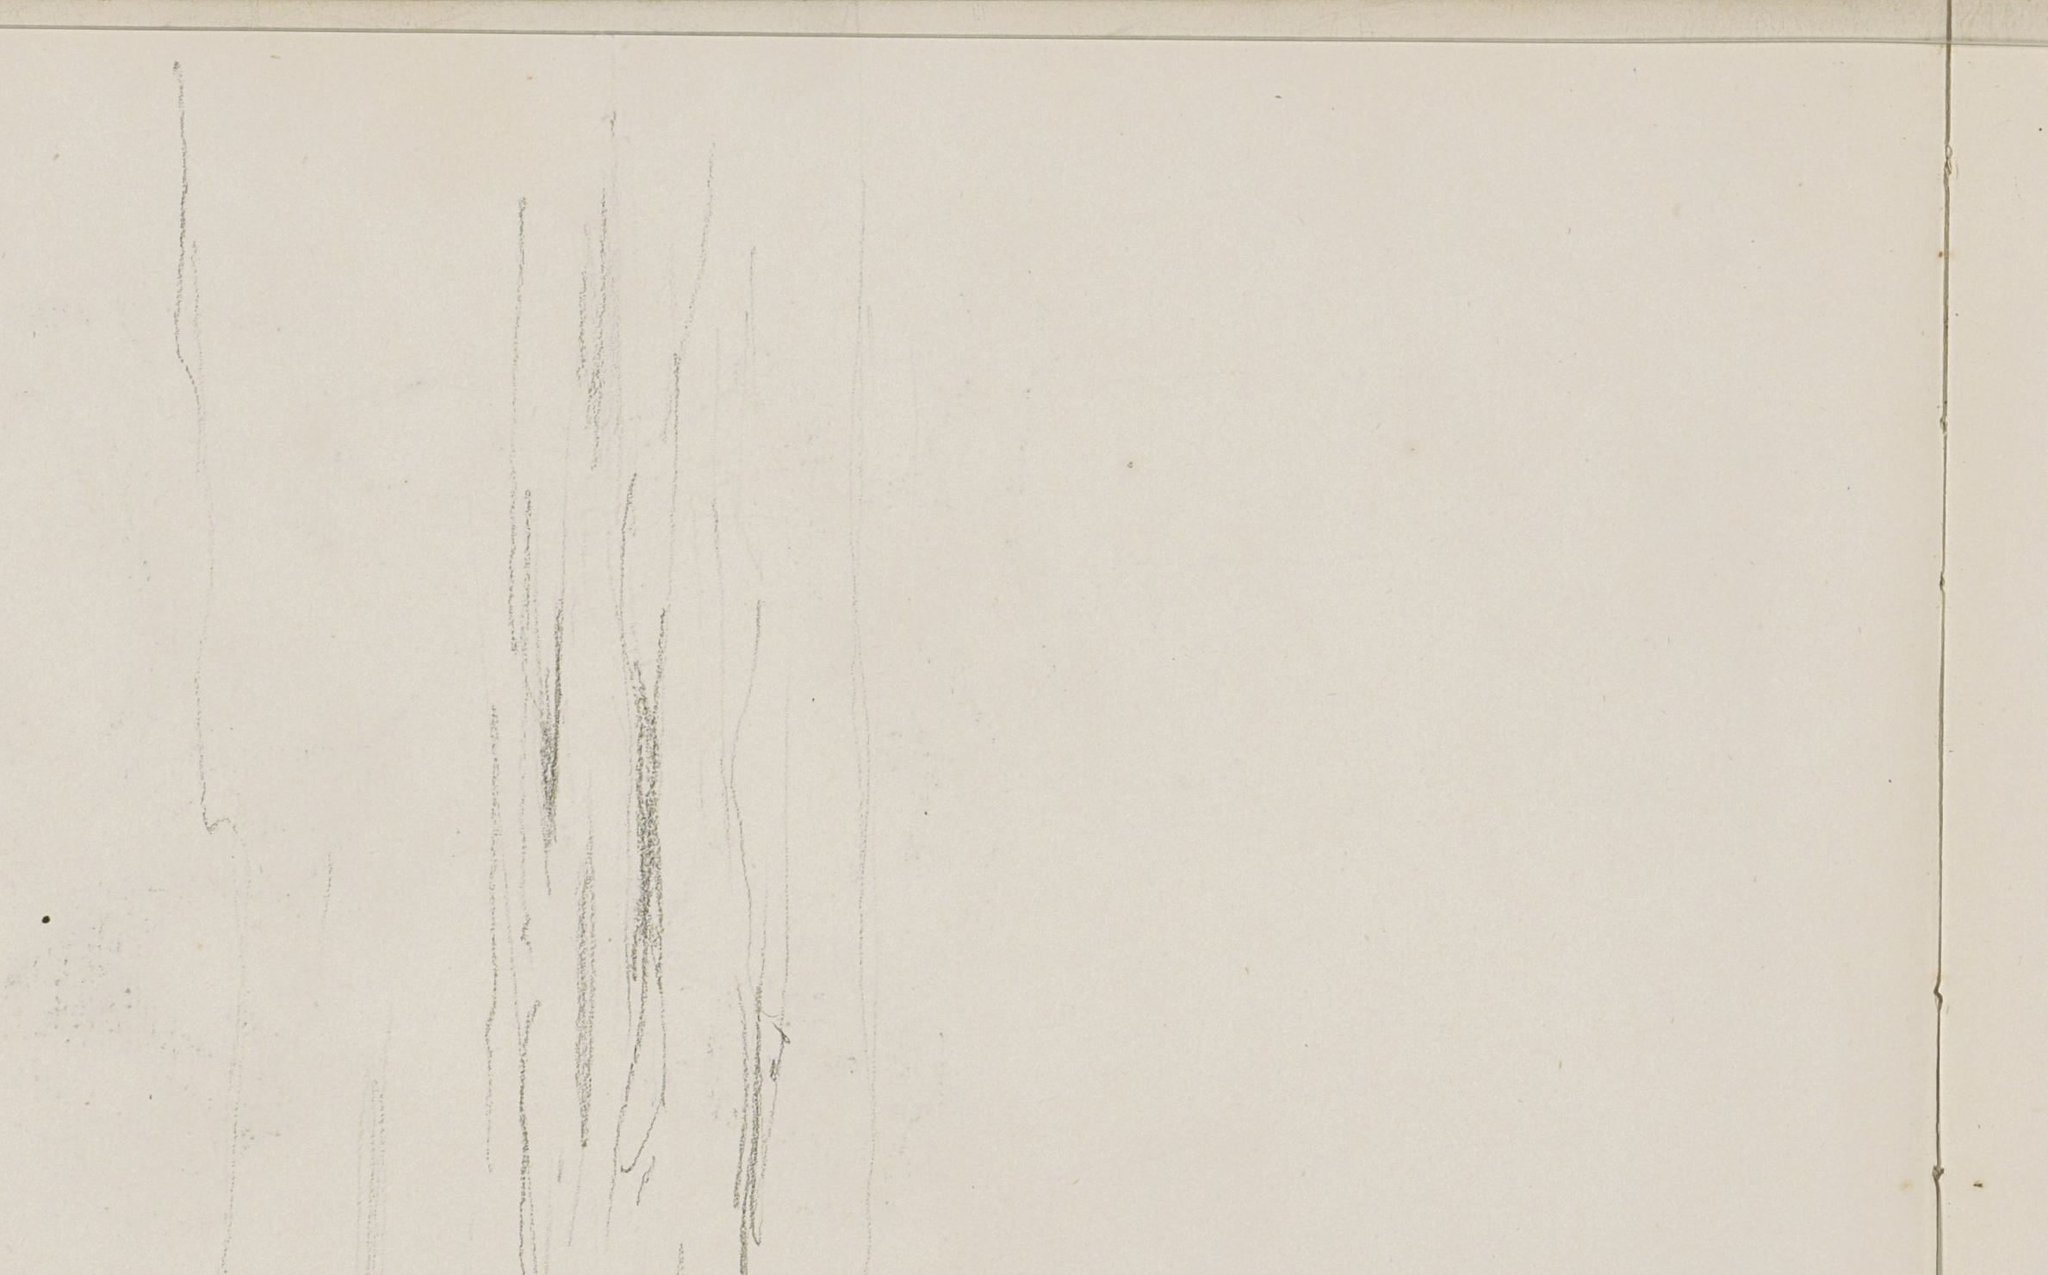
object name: sketchbook leaf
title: Zeegezicht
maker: a.a.l. de grammont-hubrecht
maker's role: draughtsman, painter, print maker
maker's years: 1855-1913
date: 1865-1913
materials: chalk, paper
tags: sea (seascape)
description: Blad 13 verso uit een schetsboek met 28 bladen.